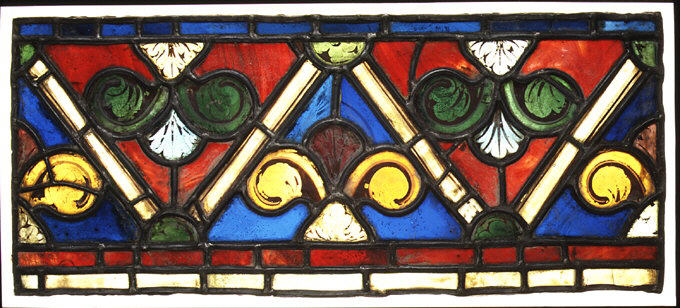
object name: fragment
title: Section of a Border with Zigzag Pattern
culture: french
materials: glass, metal, paint, pigment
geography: france